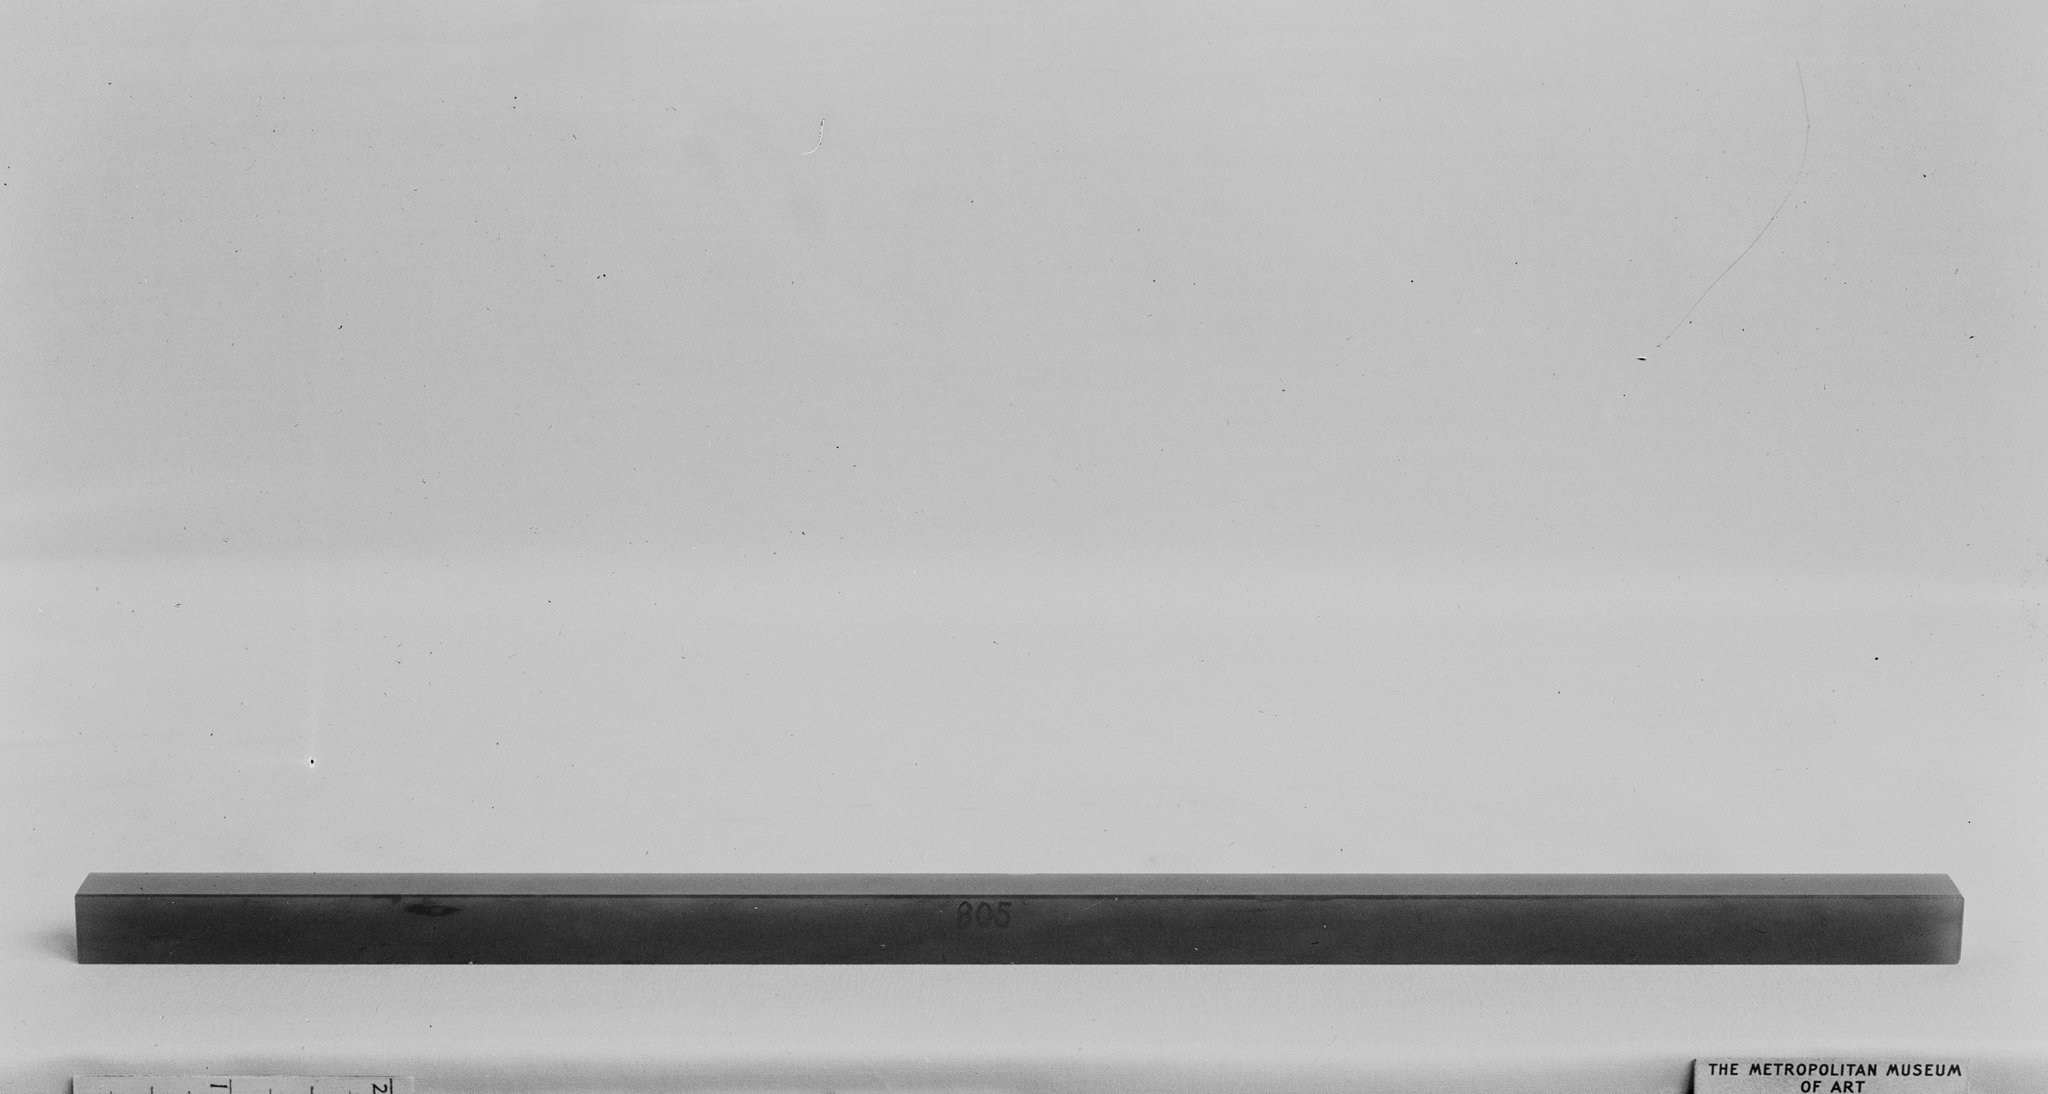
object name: bar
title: Rectangular Bar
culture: french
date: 1898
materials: jade